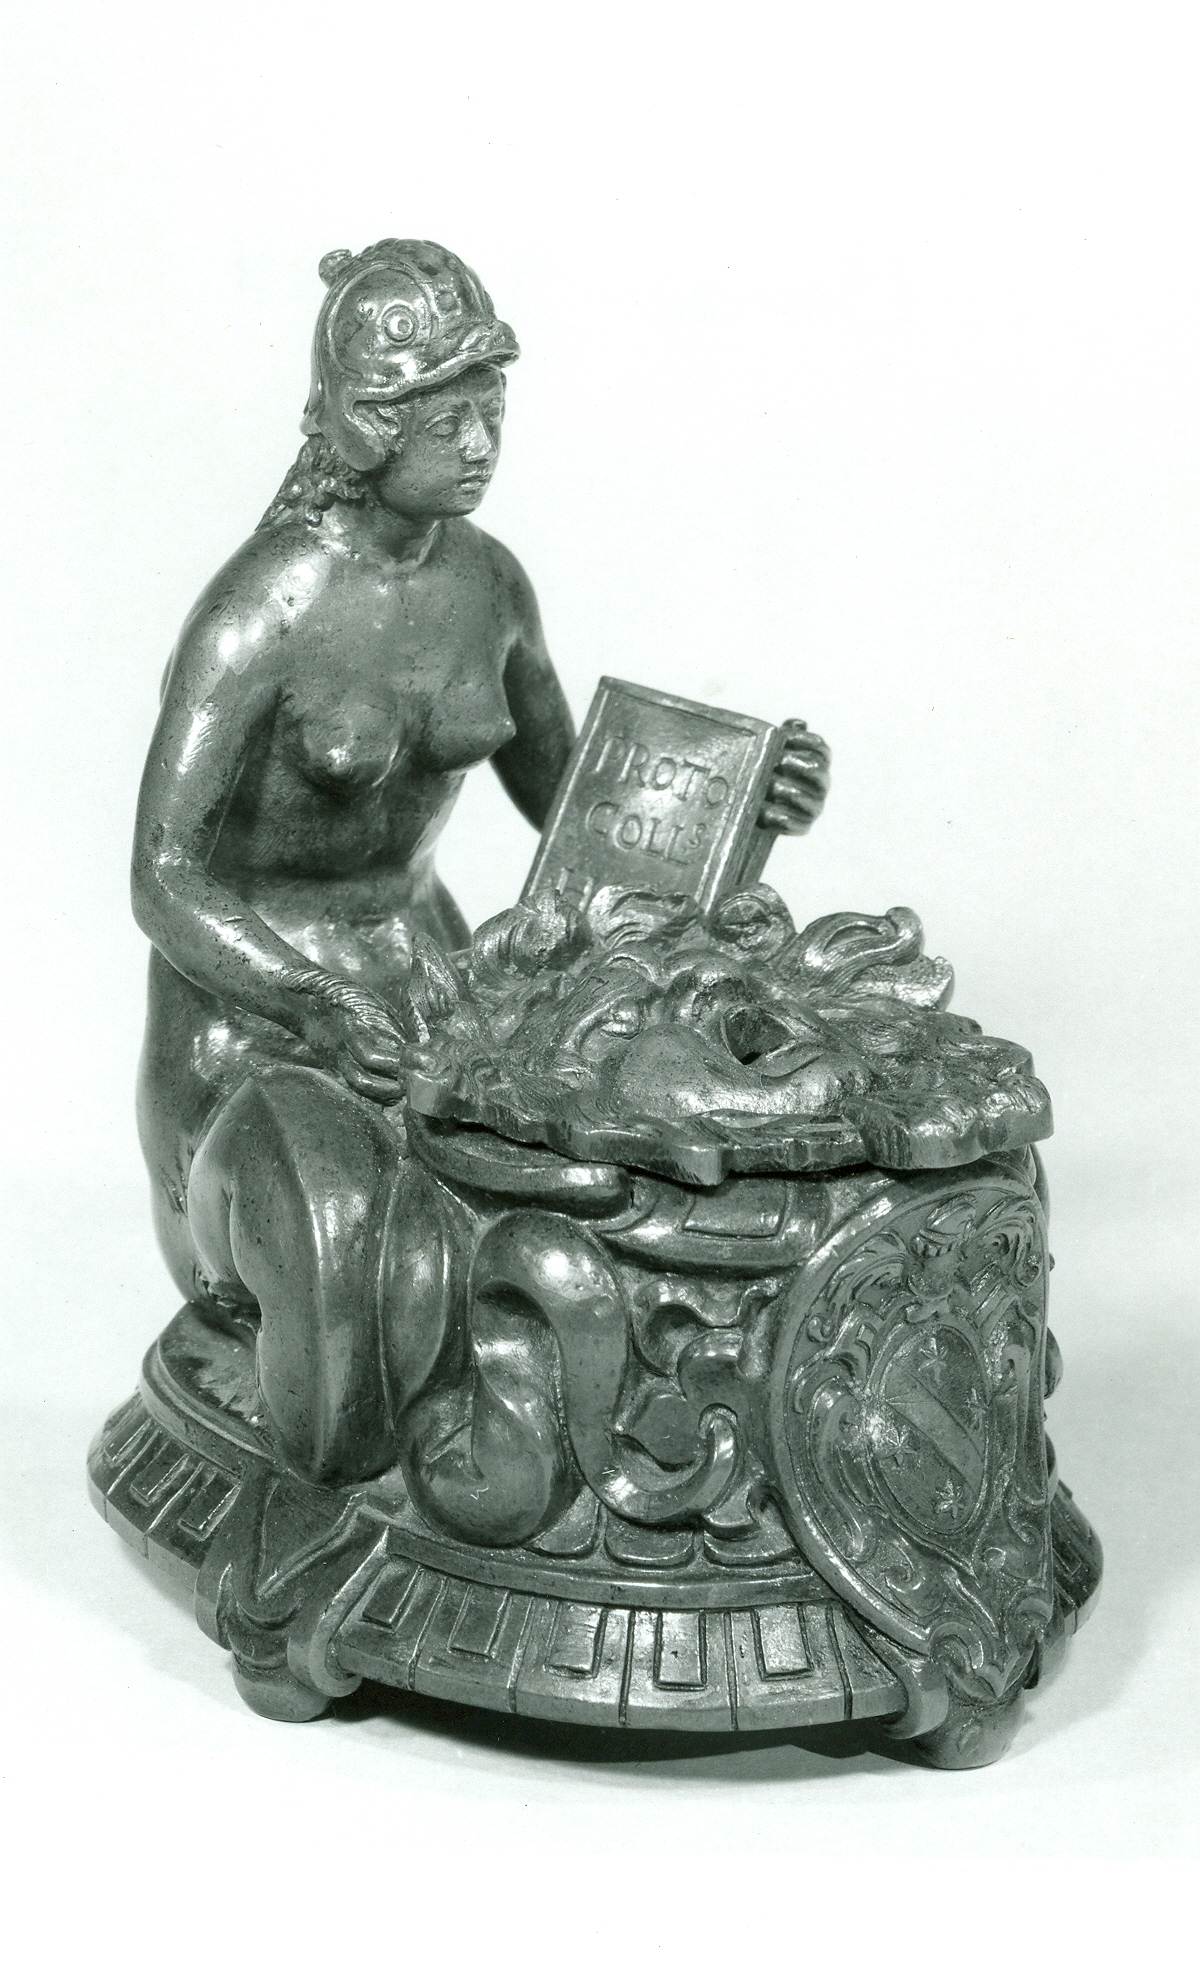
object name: inkwell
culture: italian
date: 1567-1600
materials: copper alloy, lacquer, patina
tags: female nudes,coat of arms